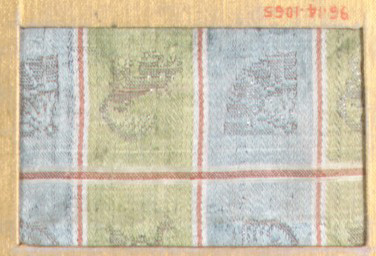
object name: piece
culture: japanese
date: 1701-1900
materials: silk